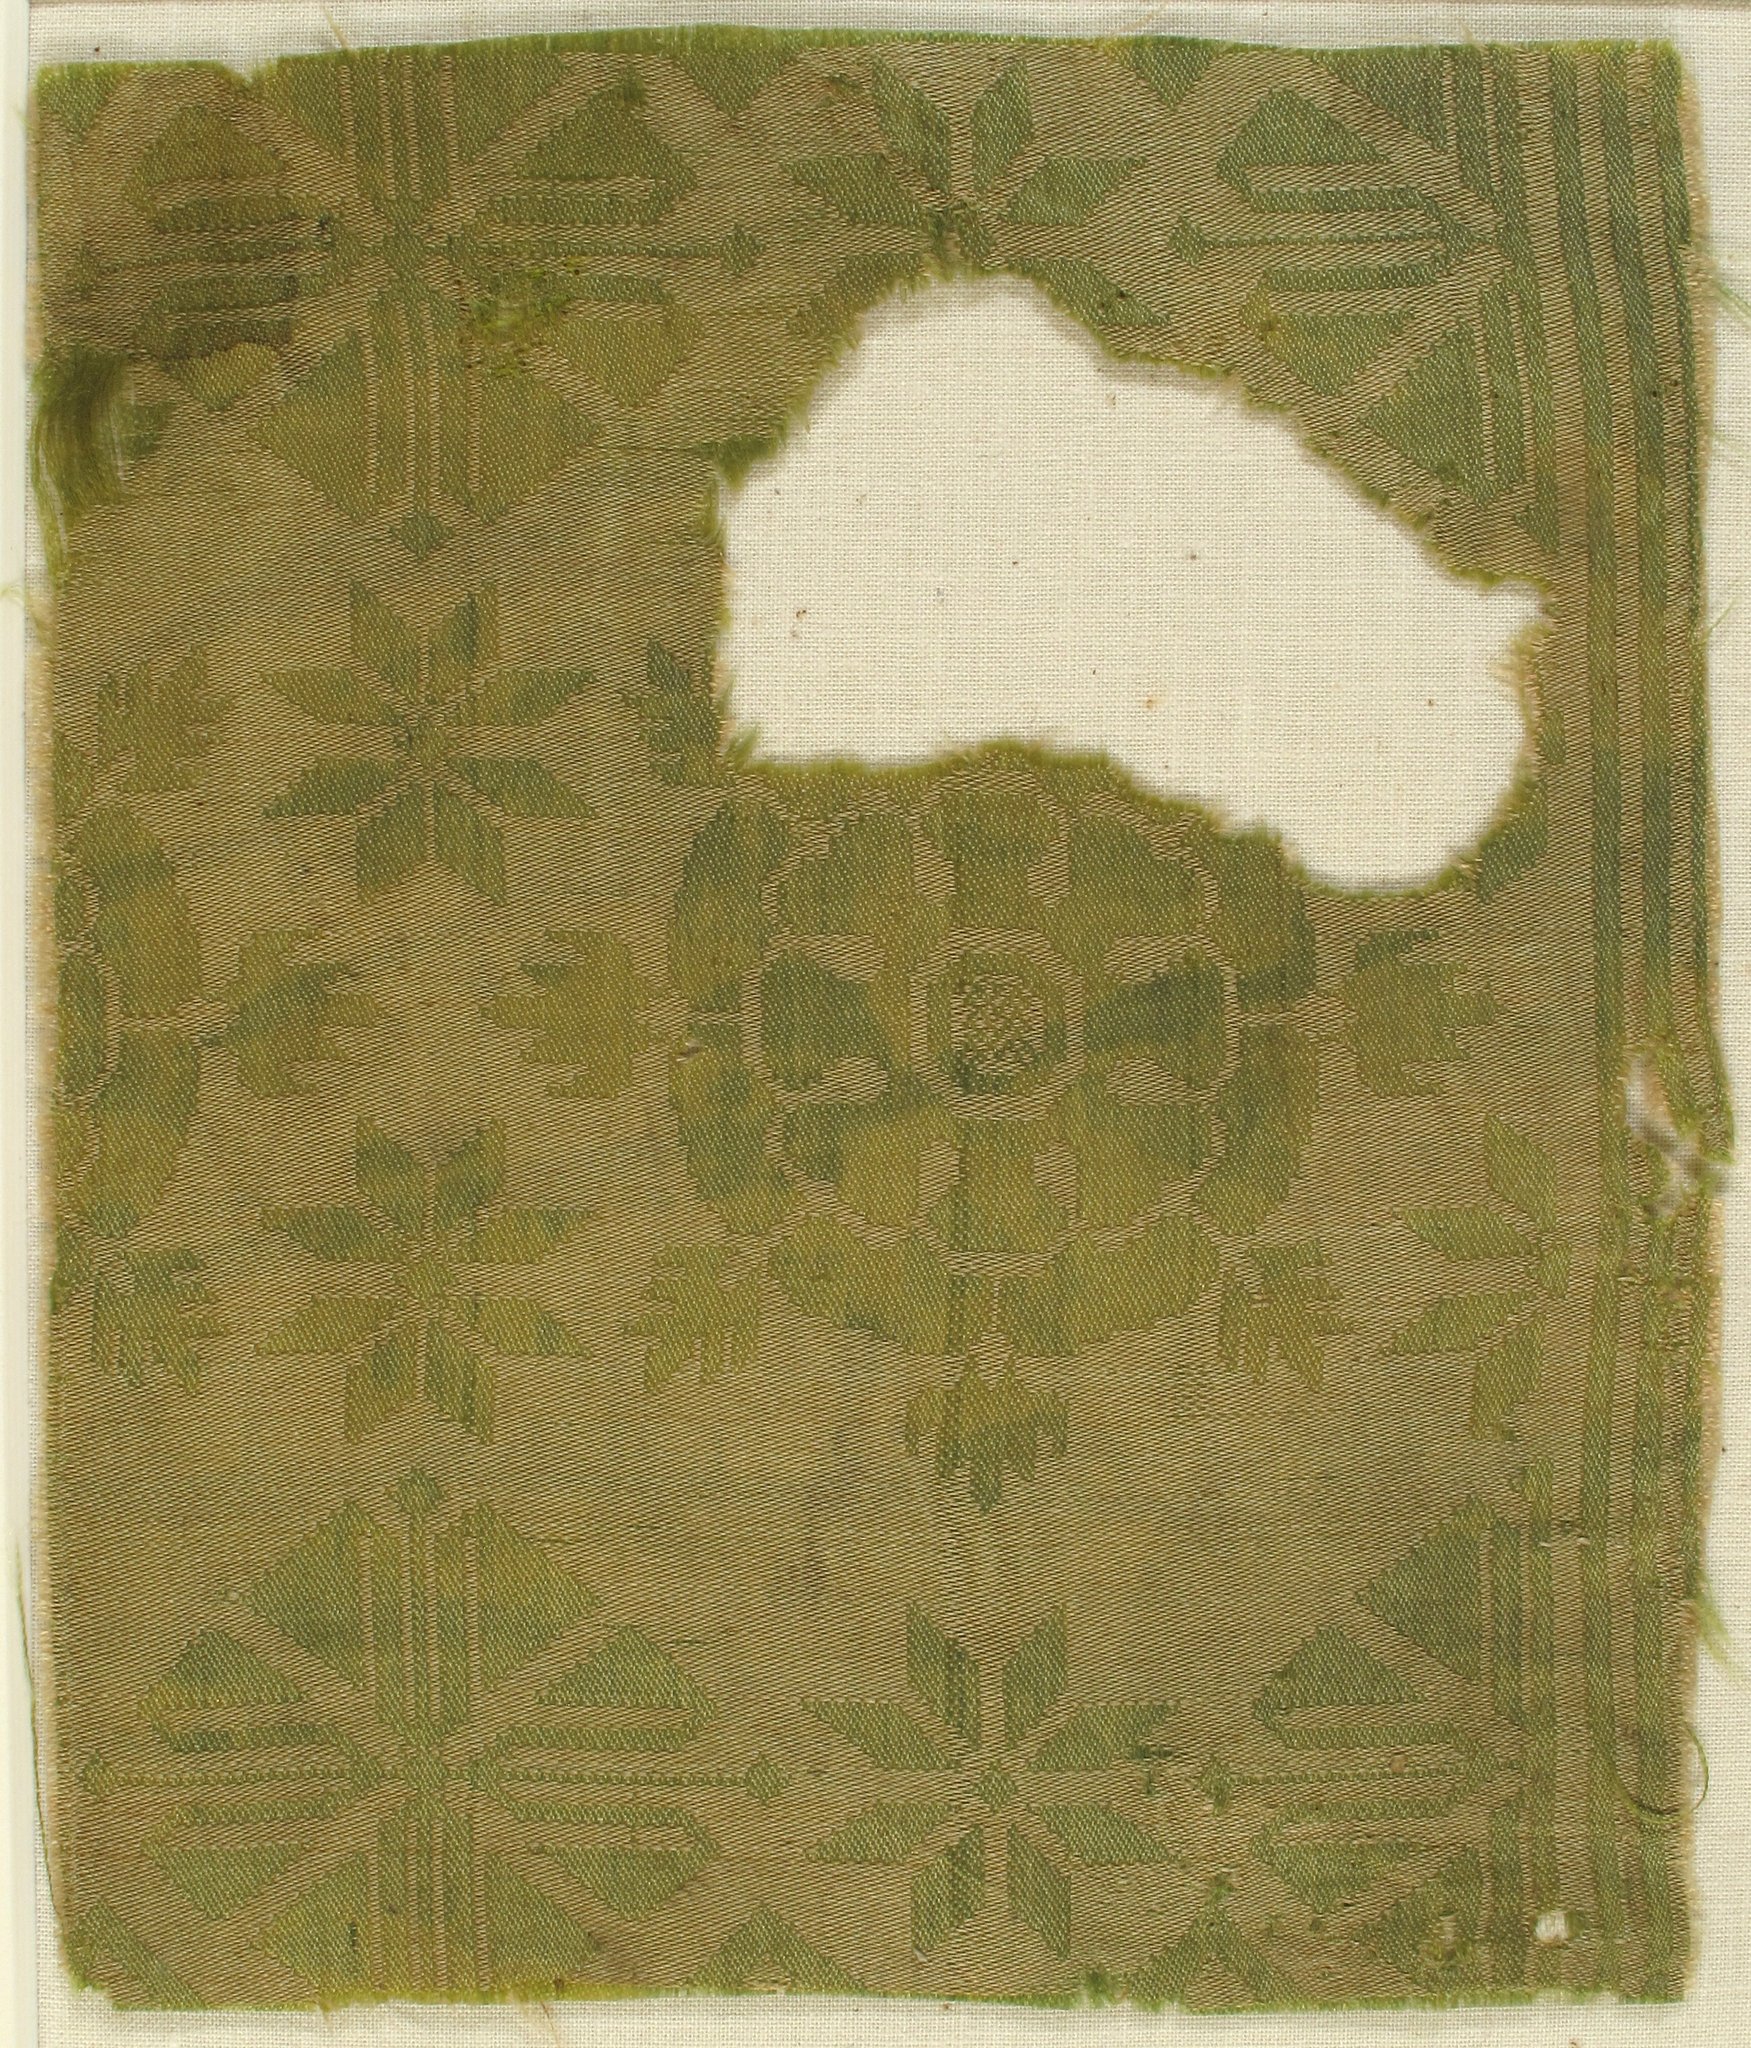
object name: textile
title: Brocade Textile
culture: italian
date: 1301-1400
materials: silk